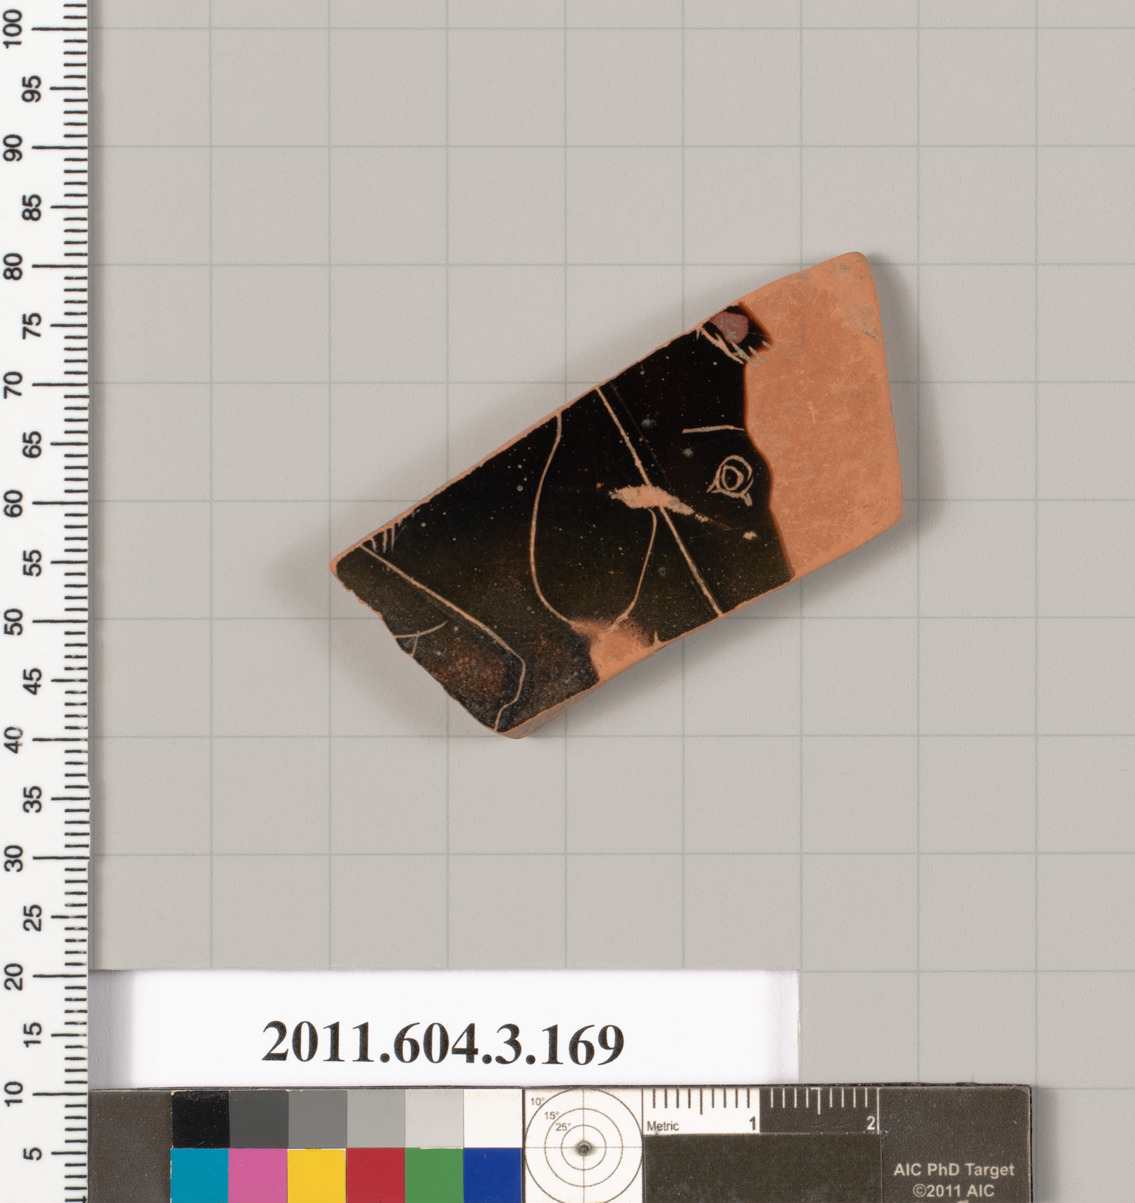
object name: amphora fragment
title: Terracotta fragment of an amphora (jar)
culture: greek, attic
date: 550-526 BCE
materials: terracotta